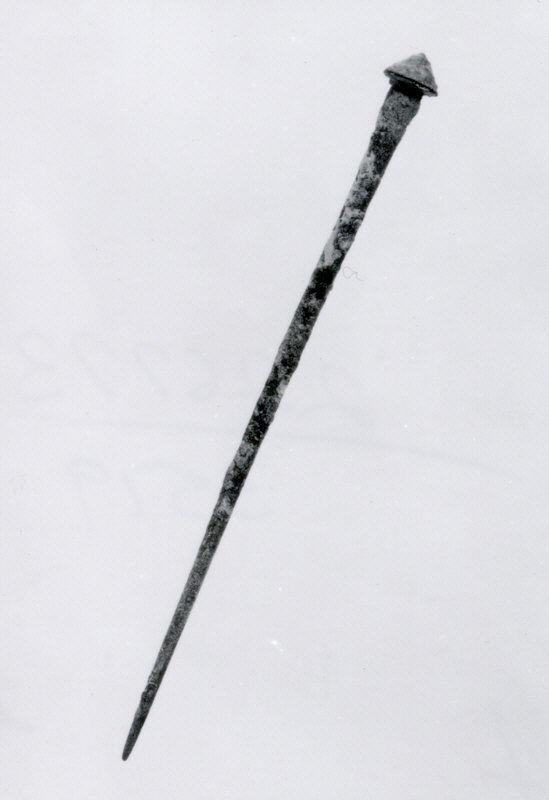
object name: pin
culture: bactria-margiana archaeological complex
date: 2333-1668 BCE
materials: copper alloy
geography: bactria-margiana